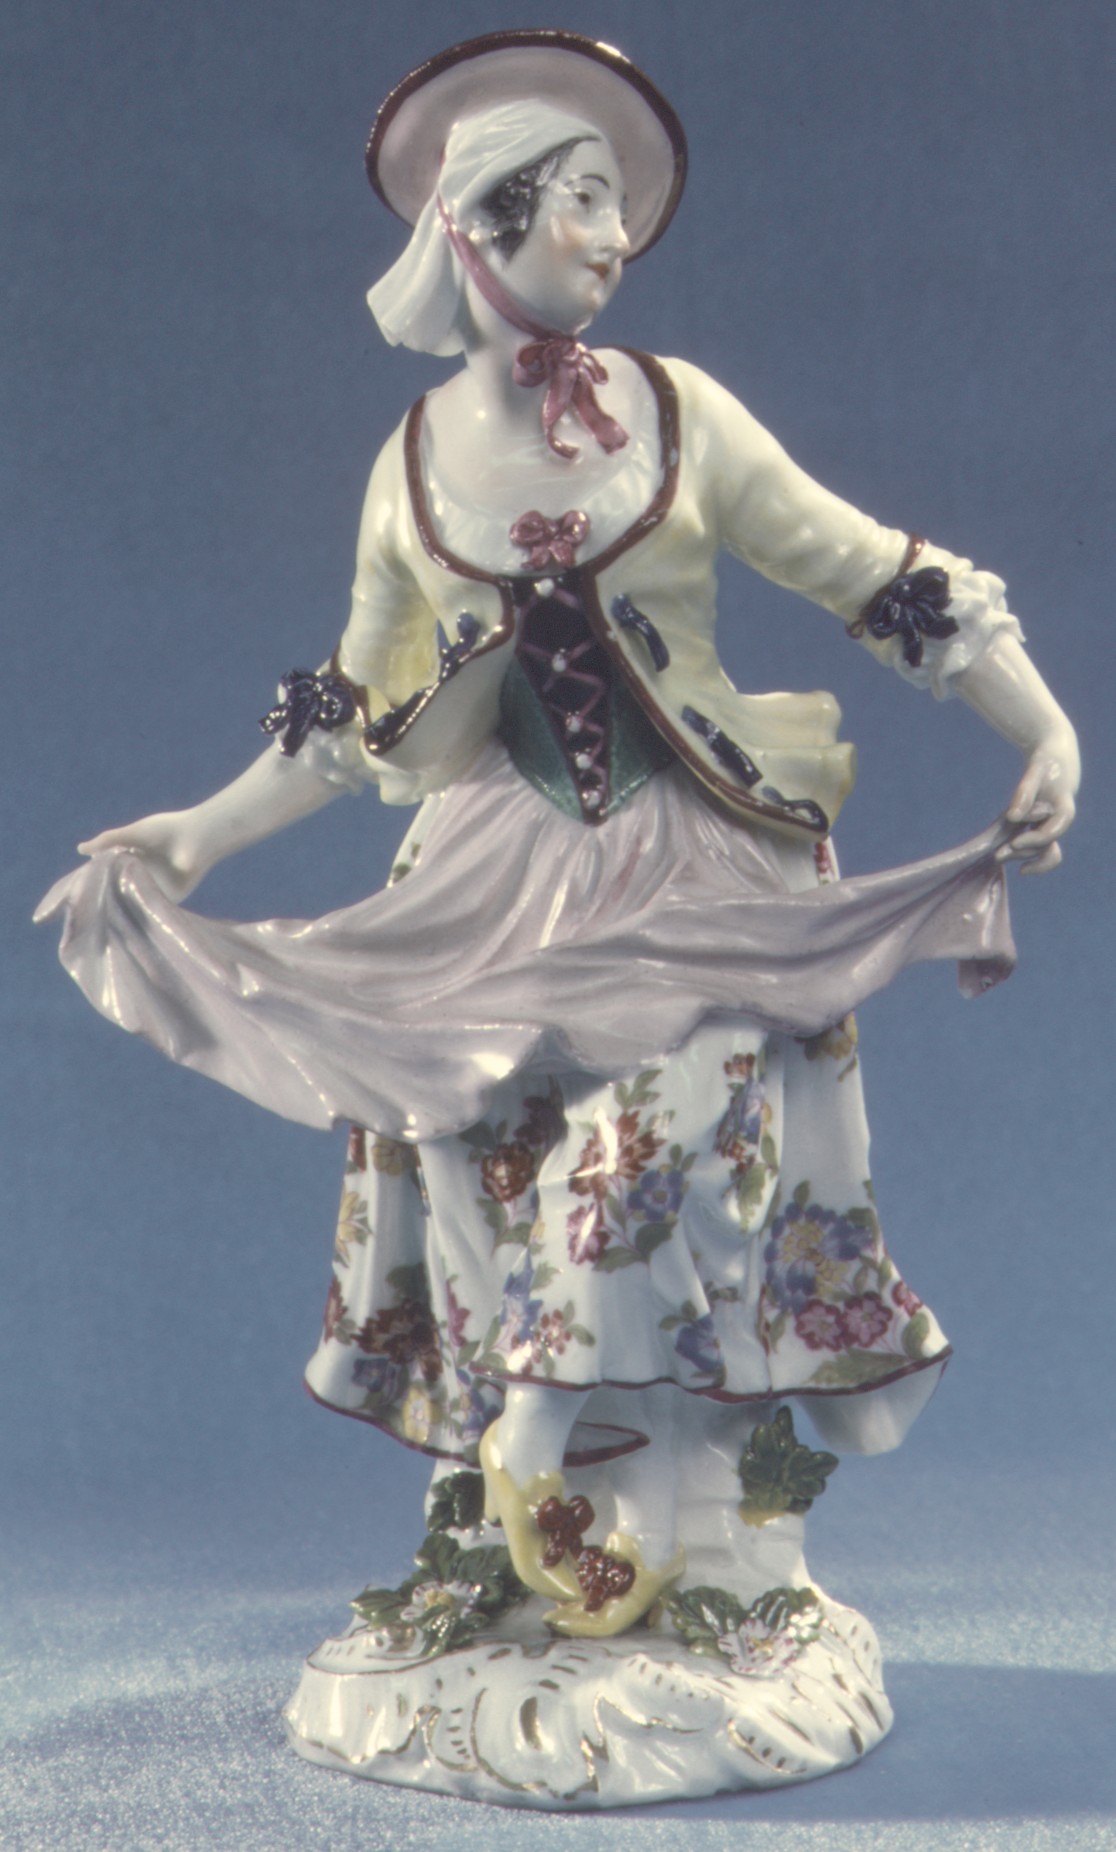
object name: figure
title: Dancing girl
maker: meissen manufactory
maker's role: manufactory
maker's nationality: german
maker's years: 1710-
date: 1750-1753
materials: hard paste porcelain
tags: girls,dancing